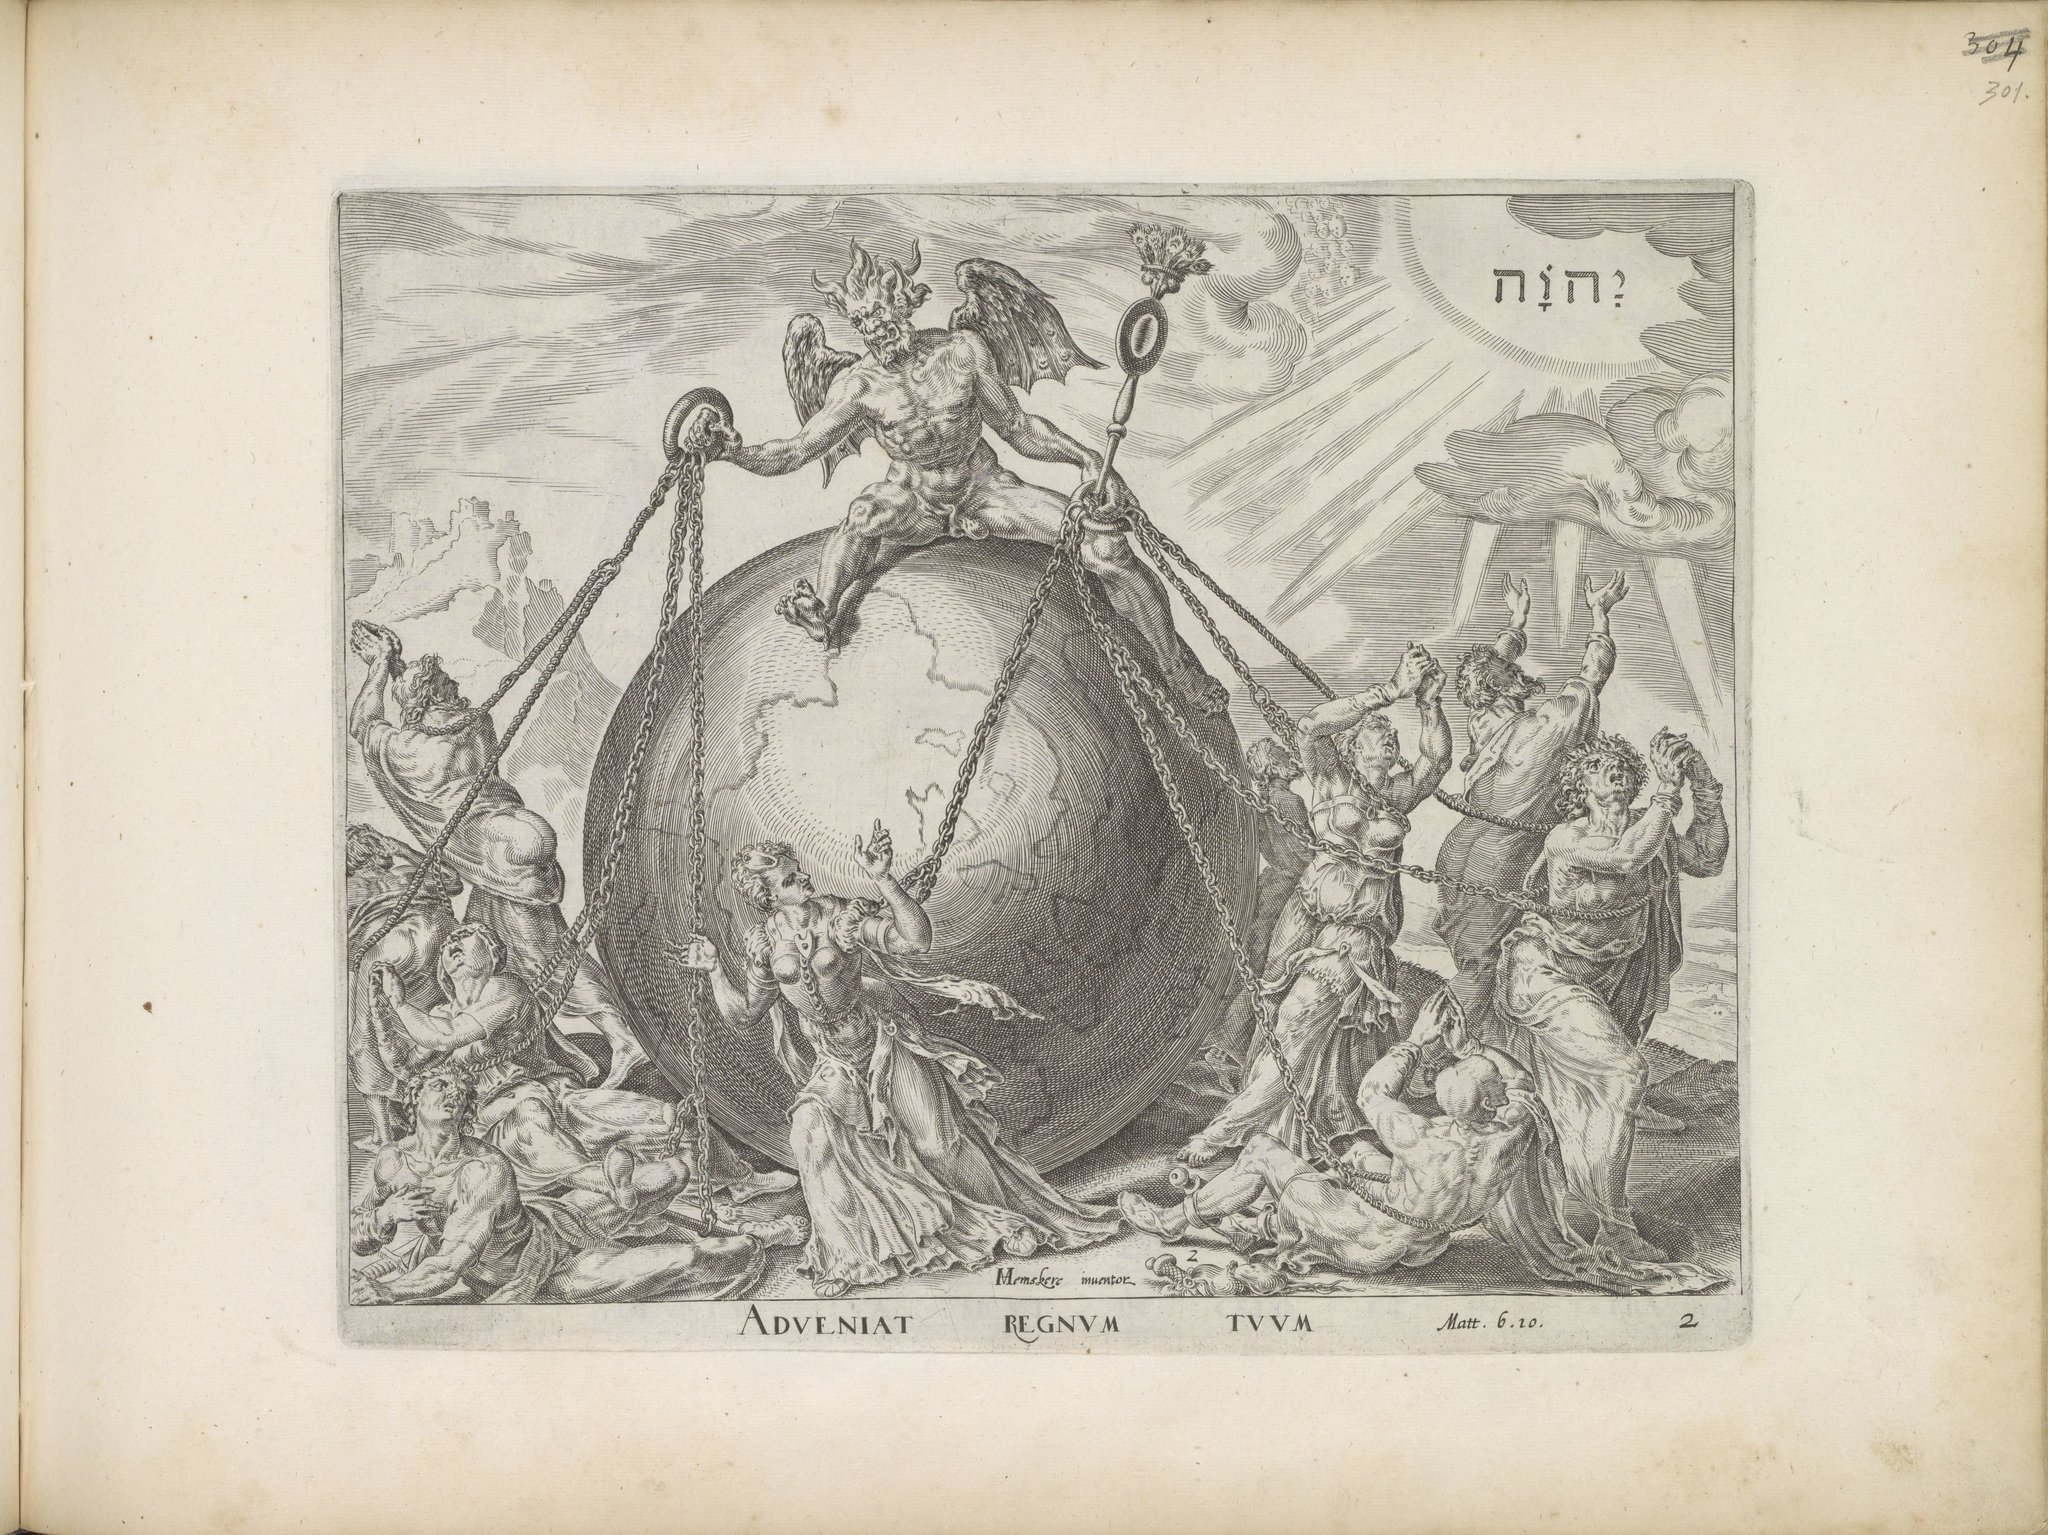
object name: album leaf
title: Theatrum Biblicum Hoc Est Historiae Sacrae Veteris et Novi Testamenti Tabulis Aeneis Expressae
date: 1569-1573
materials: paper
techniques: engraving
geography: amsterdam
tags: tetragram (in roman or hebrew script) ~ symbol of god the father, activities of devil(s), 'thy kingdom come' ~ the lord's prayer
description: Mannen en vrouwen proberen zich te ontdoen van de ketenen waarmee de duivel, die op een wereldbol zit, hen vasthoudt. Ze bidden tot God. Rechtsboven in de wolken het tetragram van God de Vader. Illustratie van de tweede regel van het Onze Vader gebed: Laat uw koninkrijk komen. Onder de voorstelling dit gedeelte van het Onze Vader in het Latijn en een verwijzing naar de Bijbeltekst in Mat. 6:10. Deze prent maakt deel uit van een album.